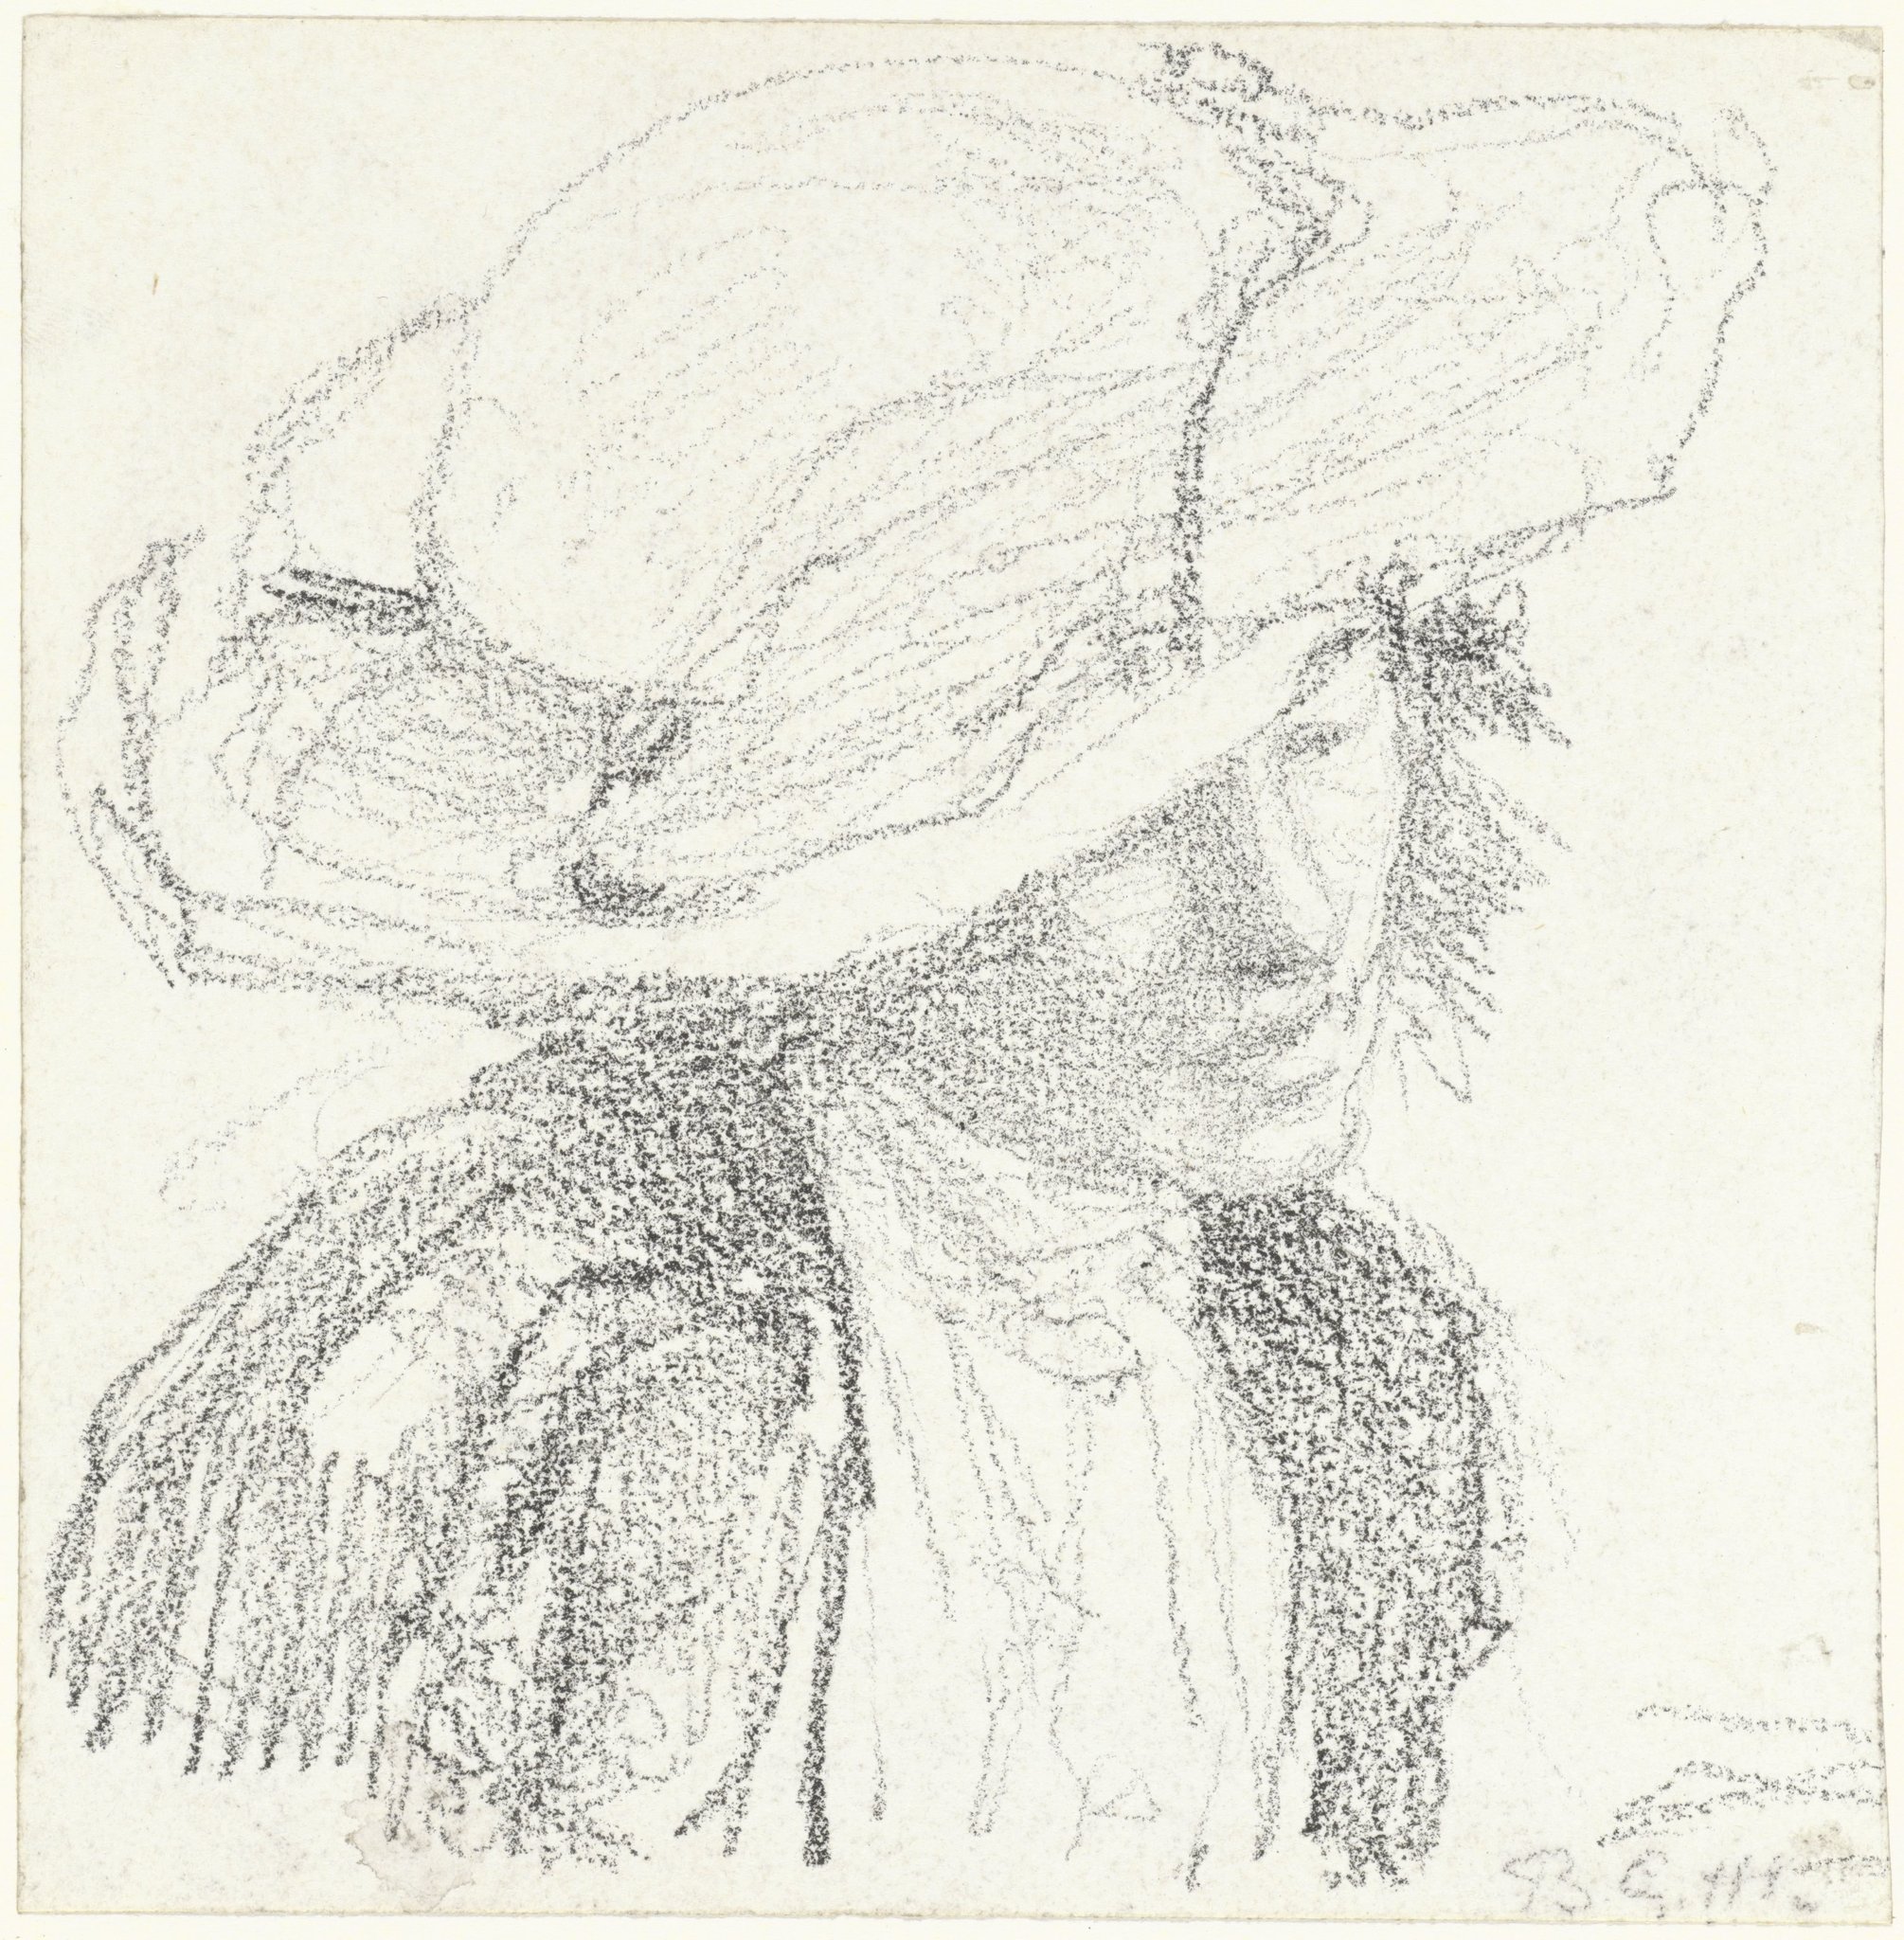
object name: drawing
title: Dame met een hoed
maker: a.a.l. de grammont-hubrecht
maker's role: draughtsman, painter, print maker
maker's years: 1855-1913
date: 1865-1913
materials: chalk, paper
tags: anonymous historical person portrayed alone